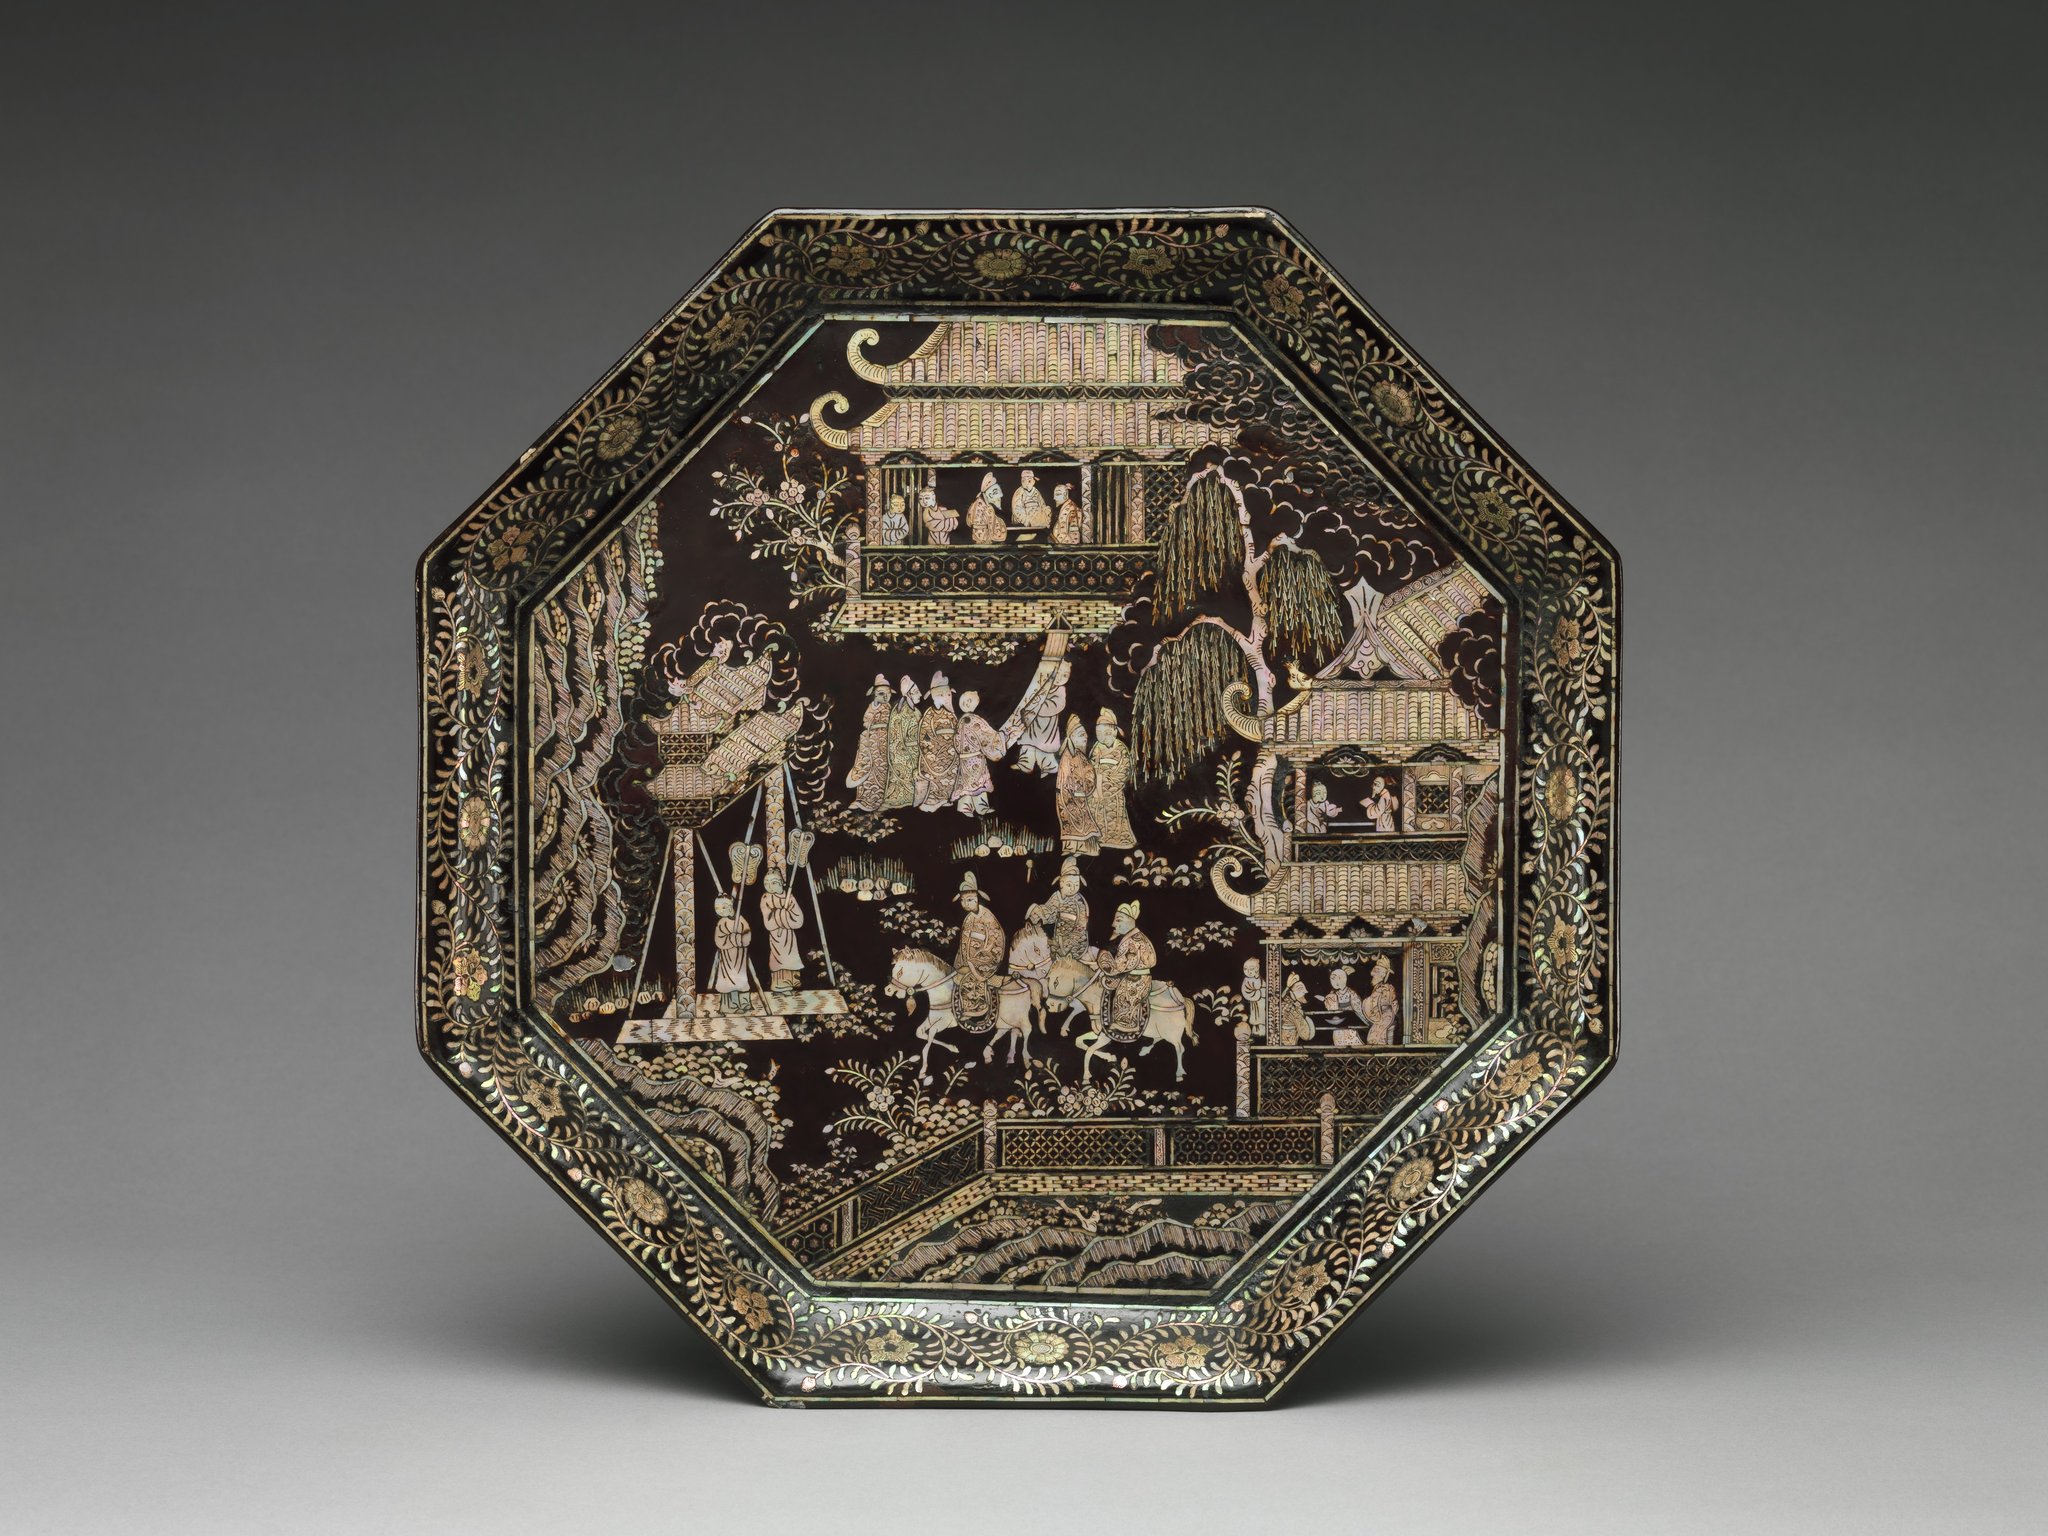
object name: tray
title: Tray with scholars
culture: chinese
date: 1401-1500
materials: lacquer, mother of pearl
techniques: inlay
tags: buildings,men,horses